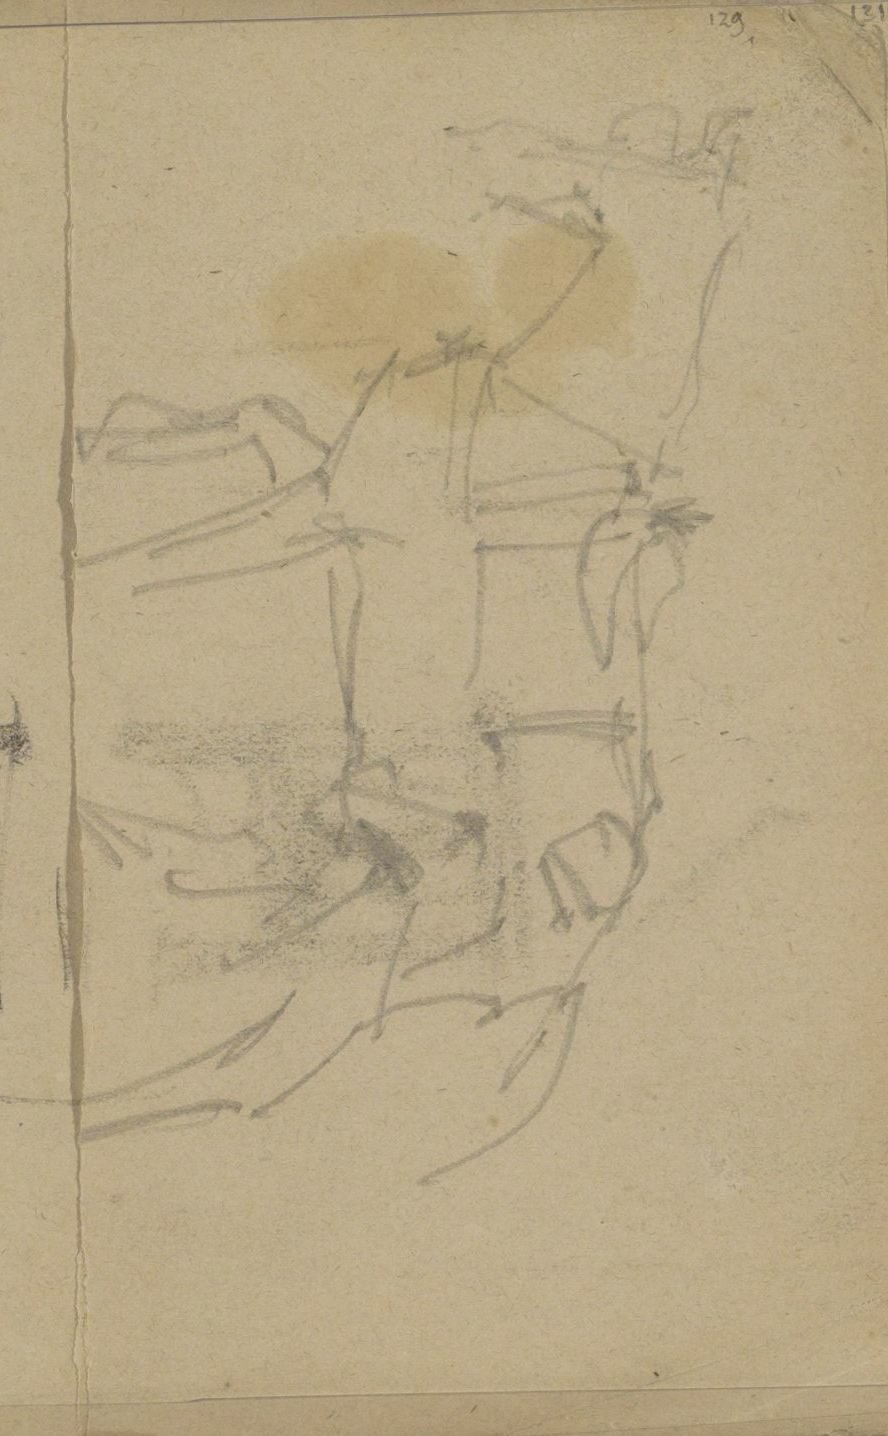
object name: sketchbook leaf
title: Paard met tuig en oogkleppen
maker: george hendrik breitner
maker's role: draughtsman, painter, print maker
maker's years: 1857-1923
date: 1881-1883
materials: paper, pencil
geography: south holland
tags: horse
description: Paard met tuig en oogkleppen. Pagina 129 uit een schetsboek met 70 bladen.